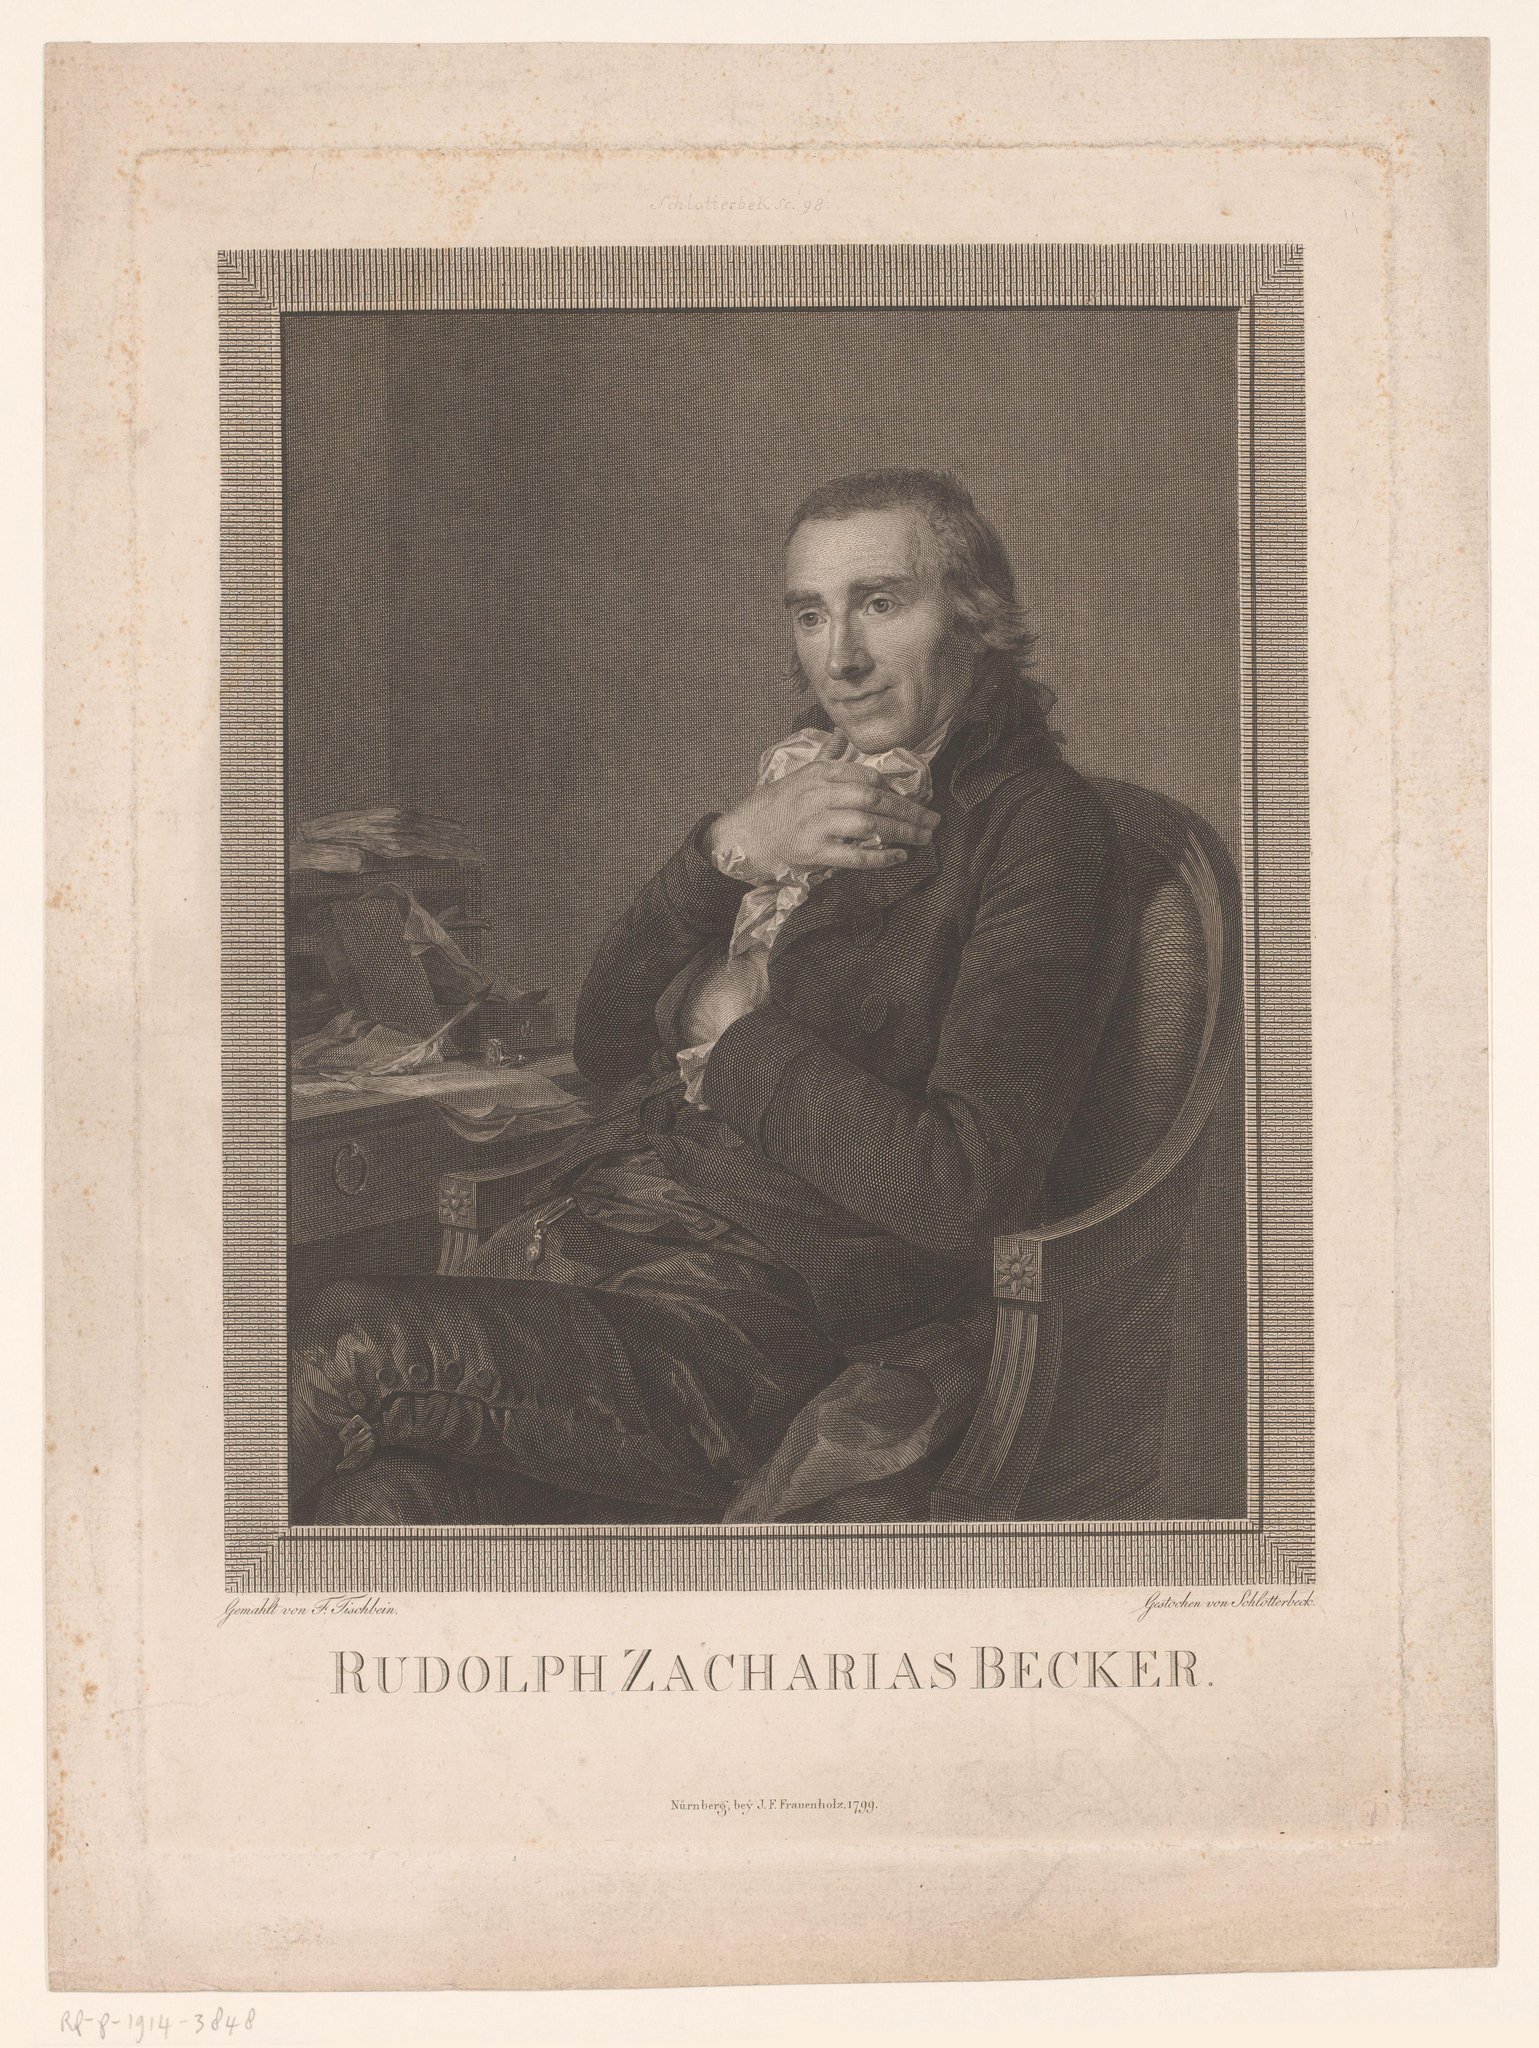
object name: print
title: Portret van Rudolph Zacharias Becker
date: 1799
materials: paper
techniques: engraving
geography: nuremberg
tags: historical persons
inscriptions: collector's mark: Lugt 2228